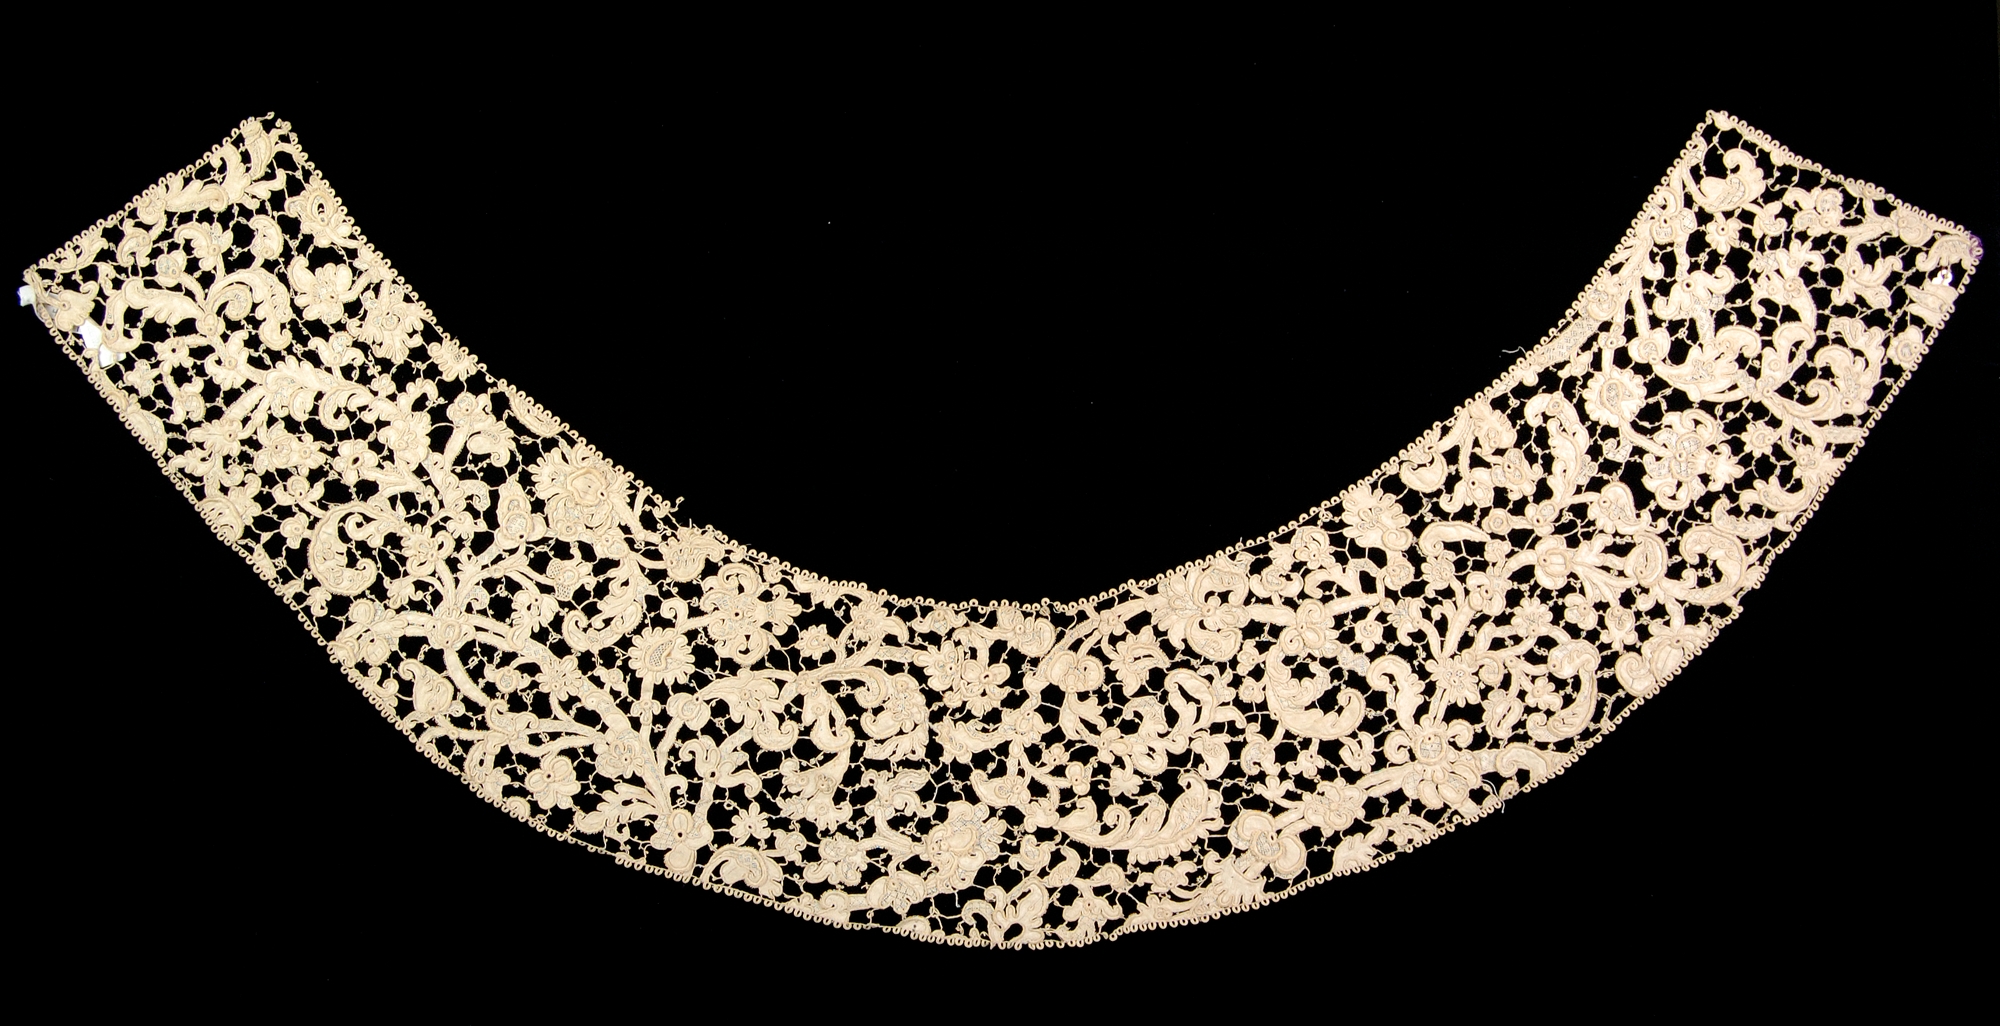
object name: bertha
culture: italian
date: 1651-1675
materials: linen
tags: flowers